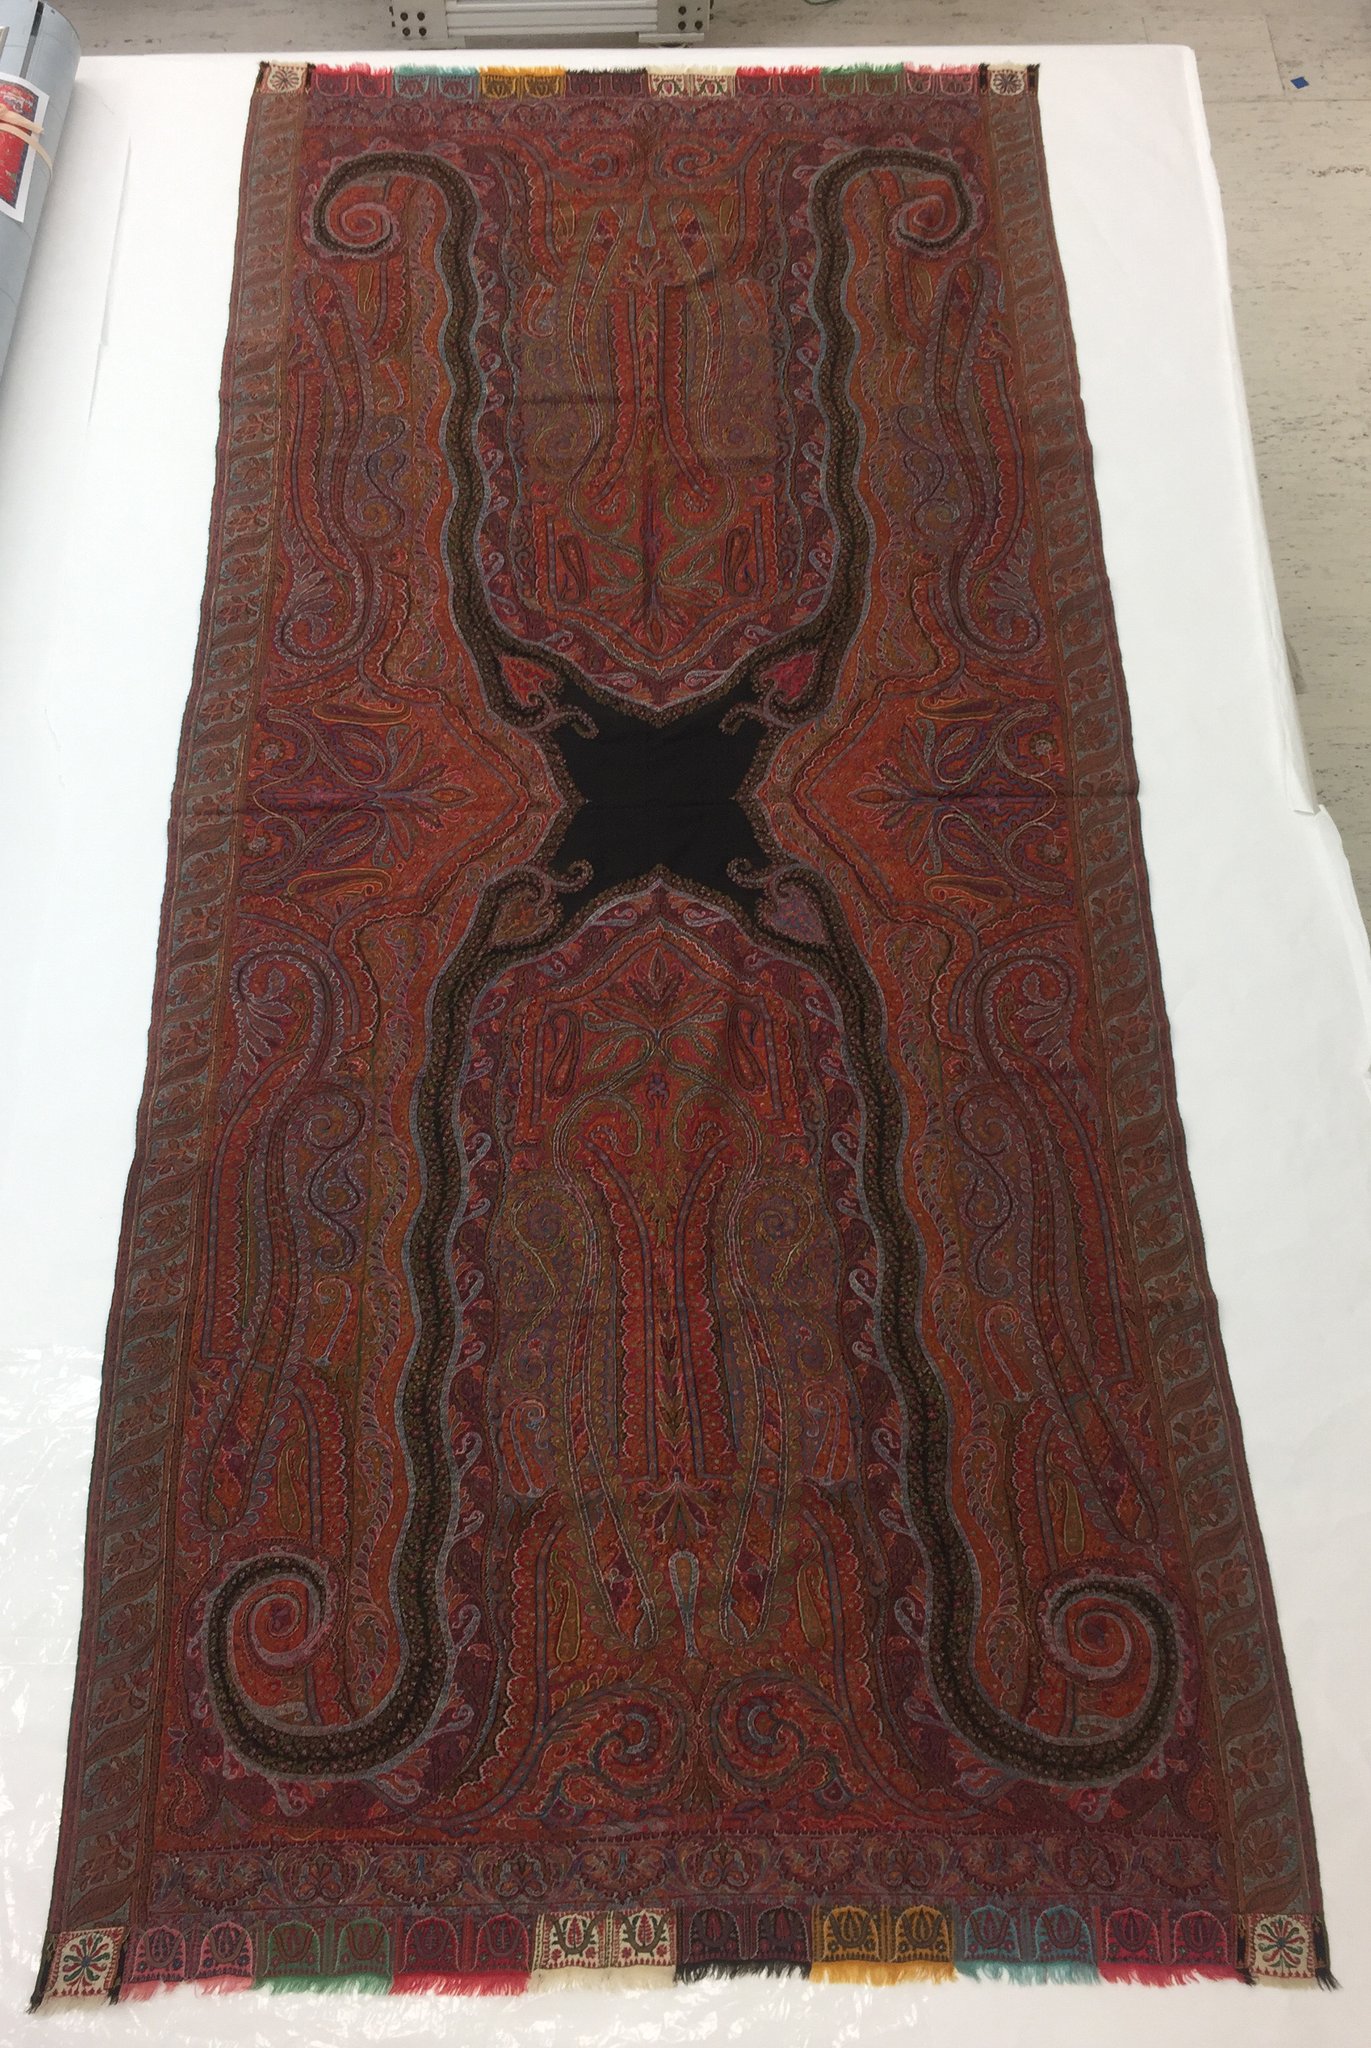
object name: shawl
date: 1801-1900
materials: wool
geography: india